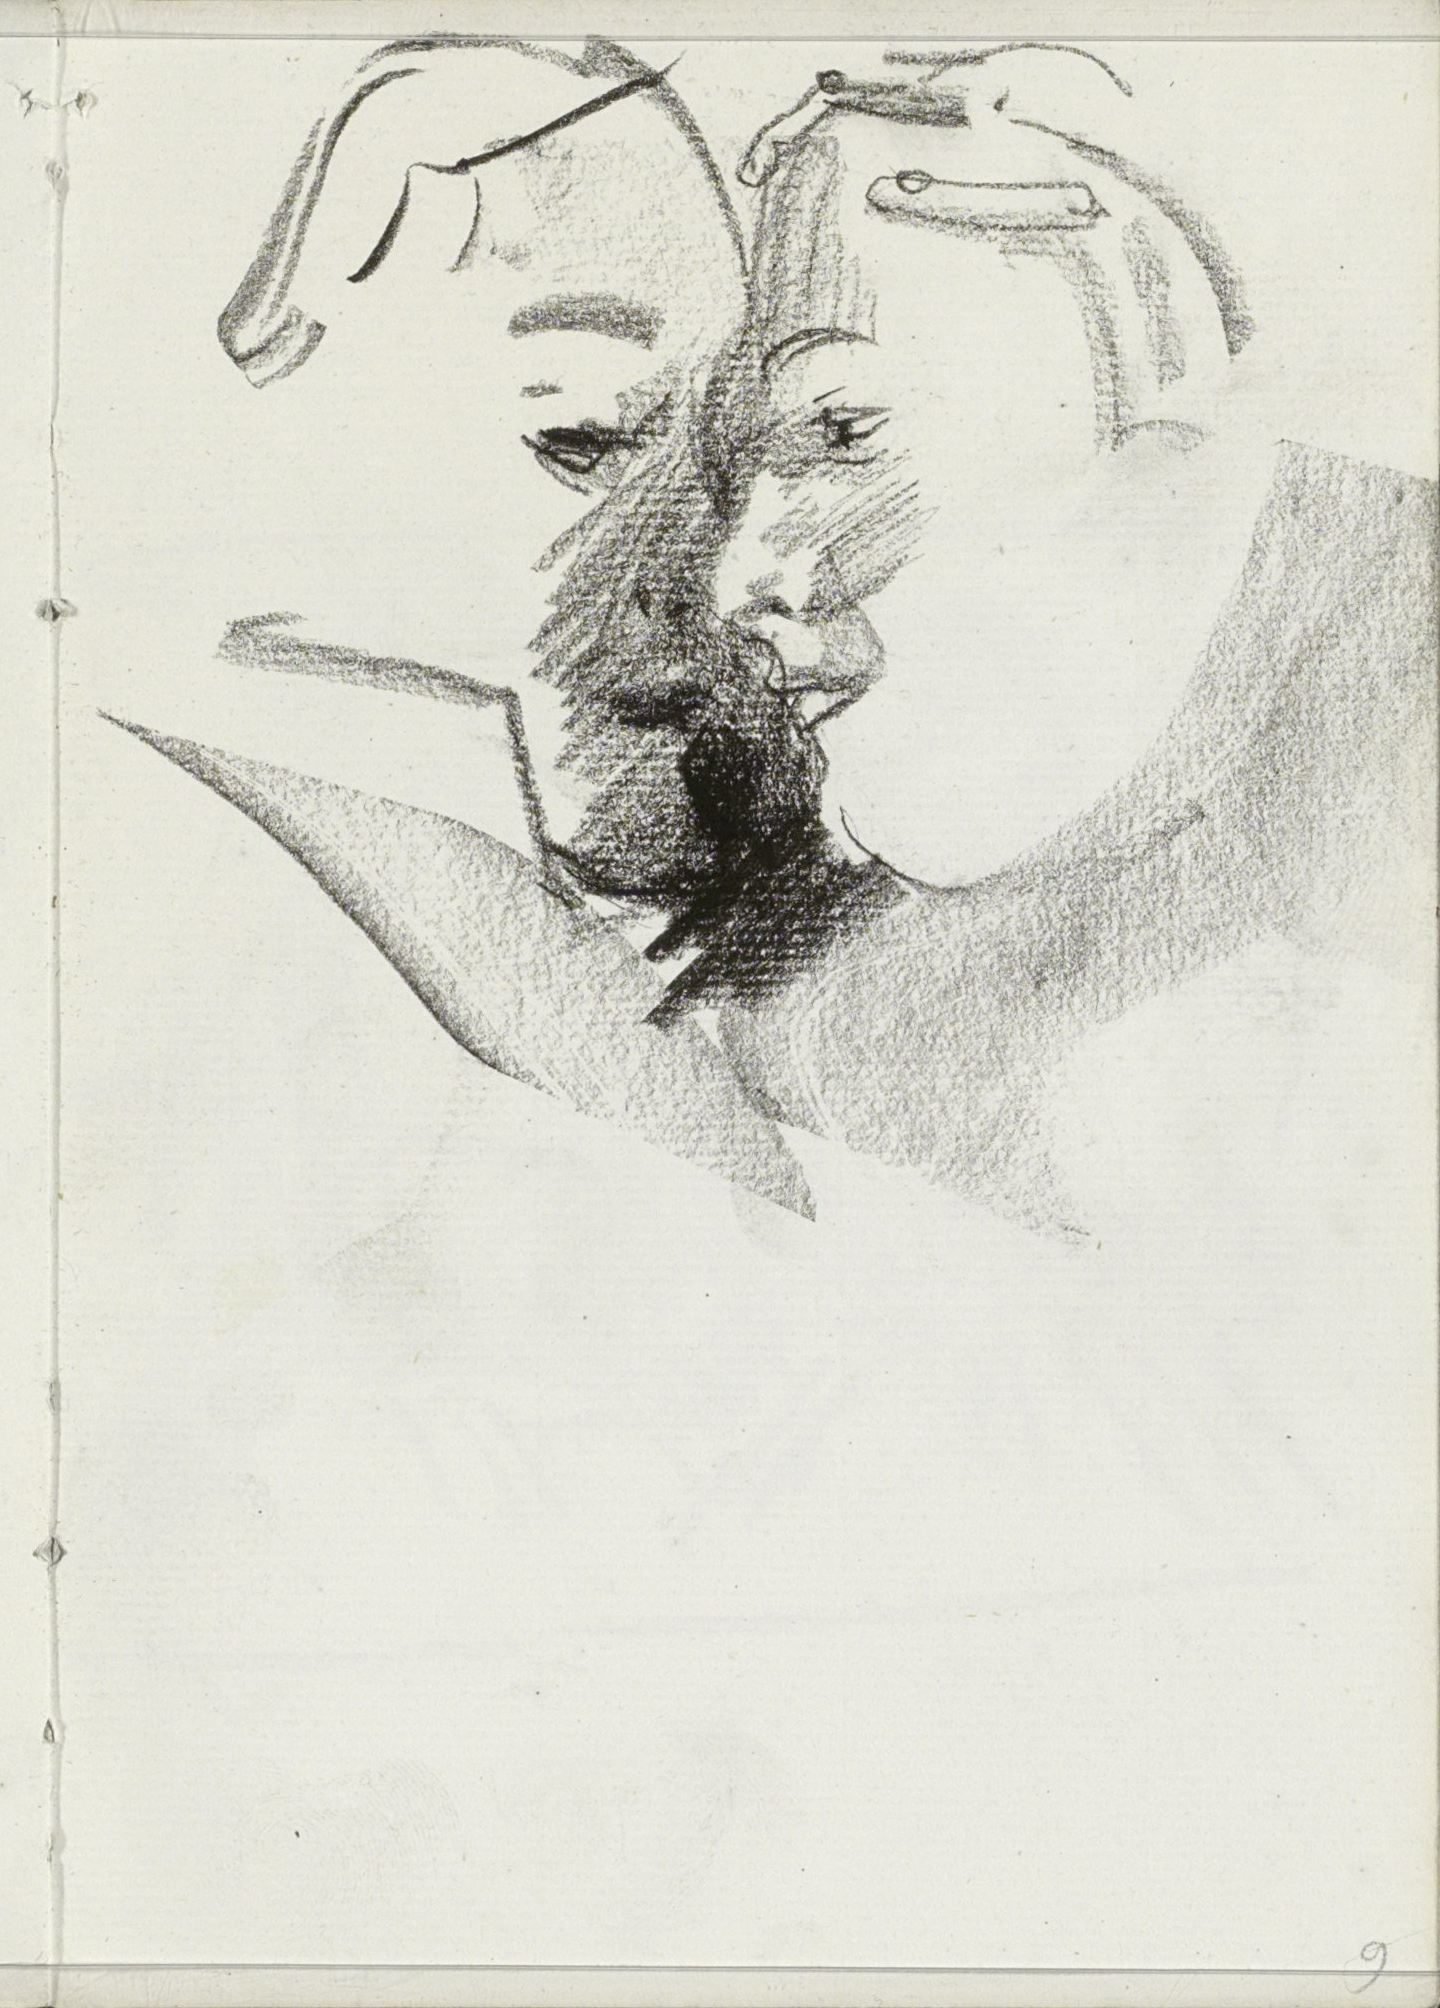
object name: sketchbook leaf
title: Twee hoofden tegen elkaar, in profiel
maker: isaac israels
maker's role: draughtsman, painter, print maker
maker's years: 1865-1934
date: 1886-1903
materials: chalk, paper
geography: amsterdam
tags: head (human) (+ sideview, profile)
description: Pagina 9 uit schetsboek XXXVII met 52 pagina's.